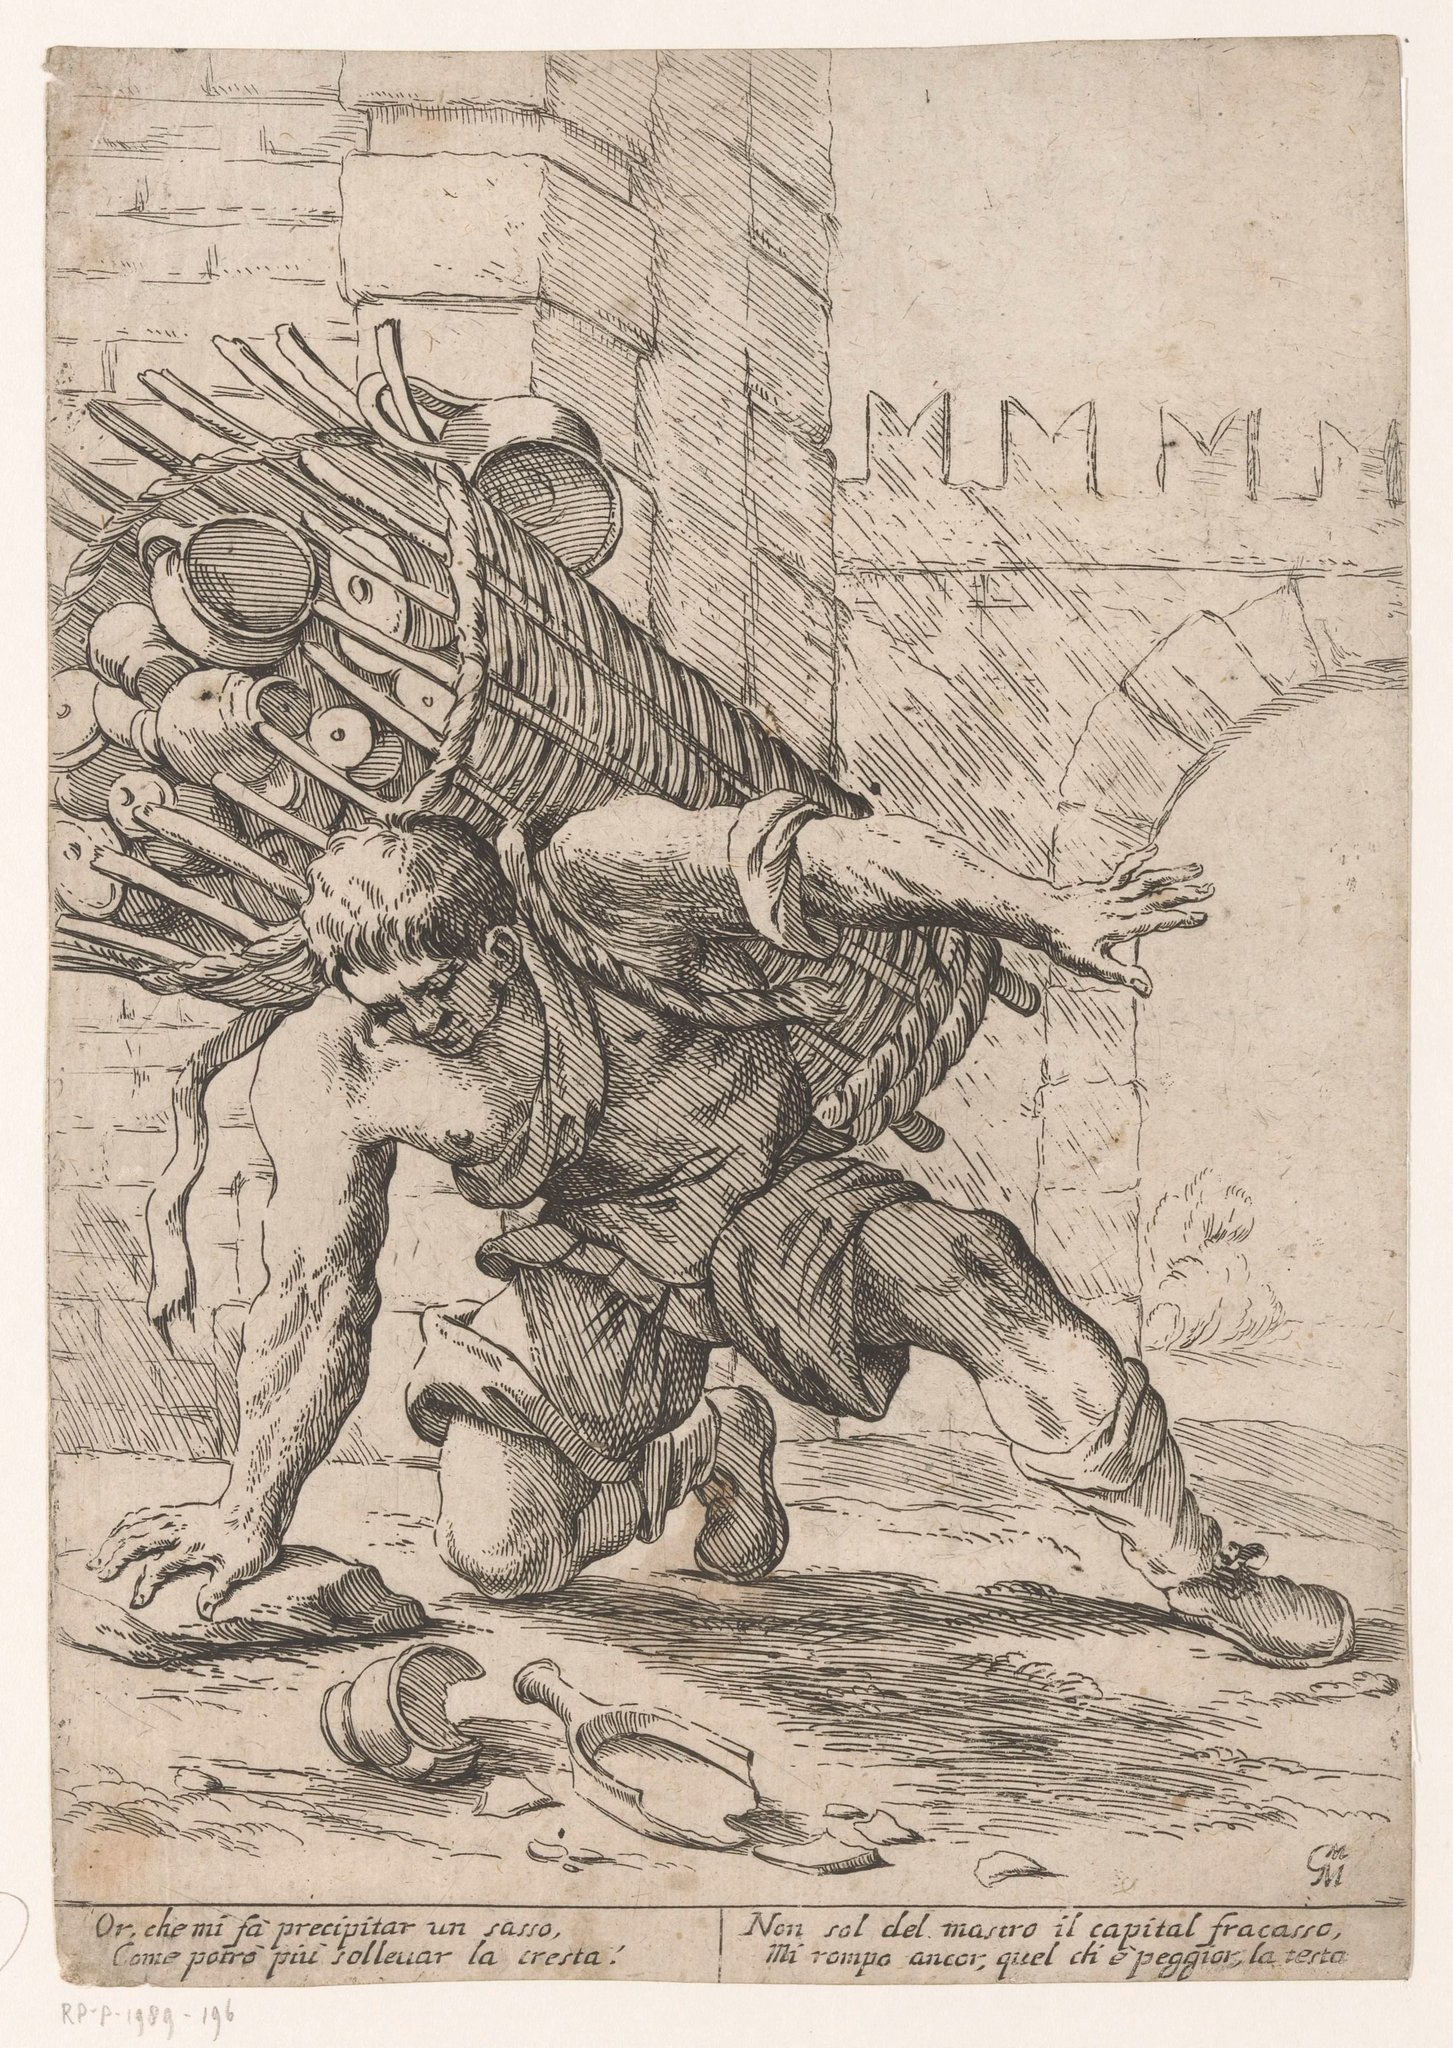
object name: print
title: Straatverkopers in Bologna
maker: giuseppe maria mitelli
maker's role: draughtsman, painter, print maker, publisher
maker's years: 1634-1718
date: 1660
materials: paper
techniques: etching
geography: italy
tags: carrying something in basket, bag, rucksack, etc., street-trader, container of ceramics: jar, jug, pot, vase, stumbling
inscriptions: collector's mark: Lugt 2228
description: Een straatverkoper met een grote mand met vaatwerk op zijn rug. De man krabbelt weer op nadat hij op straat gevallen is. Twee stuks vaatwerk liggen gebroken voor hem op straat. Italiaans vers in ondermarge.